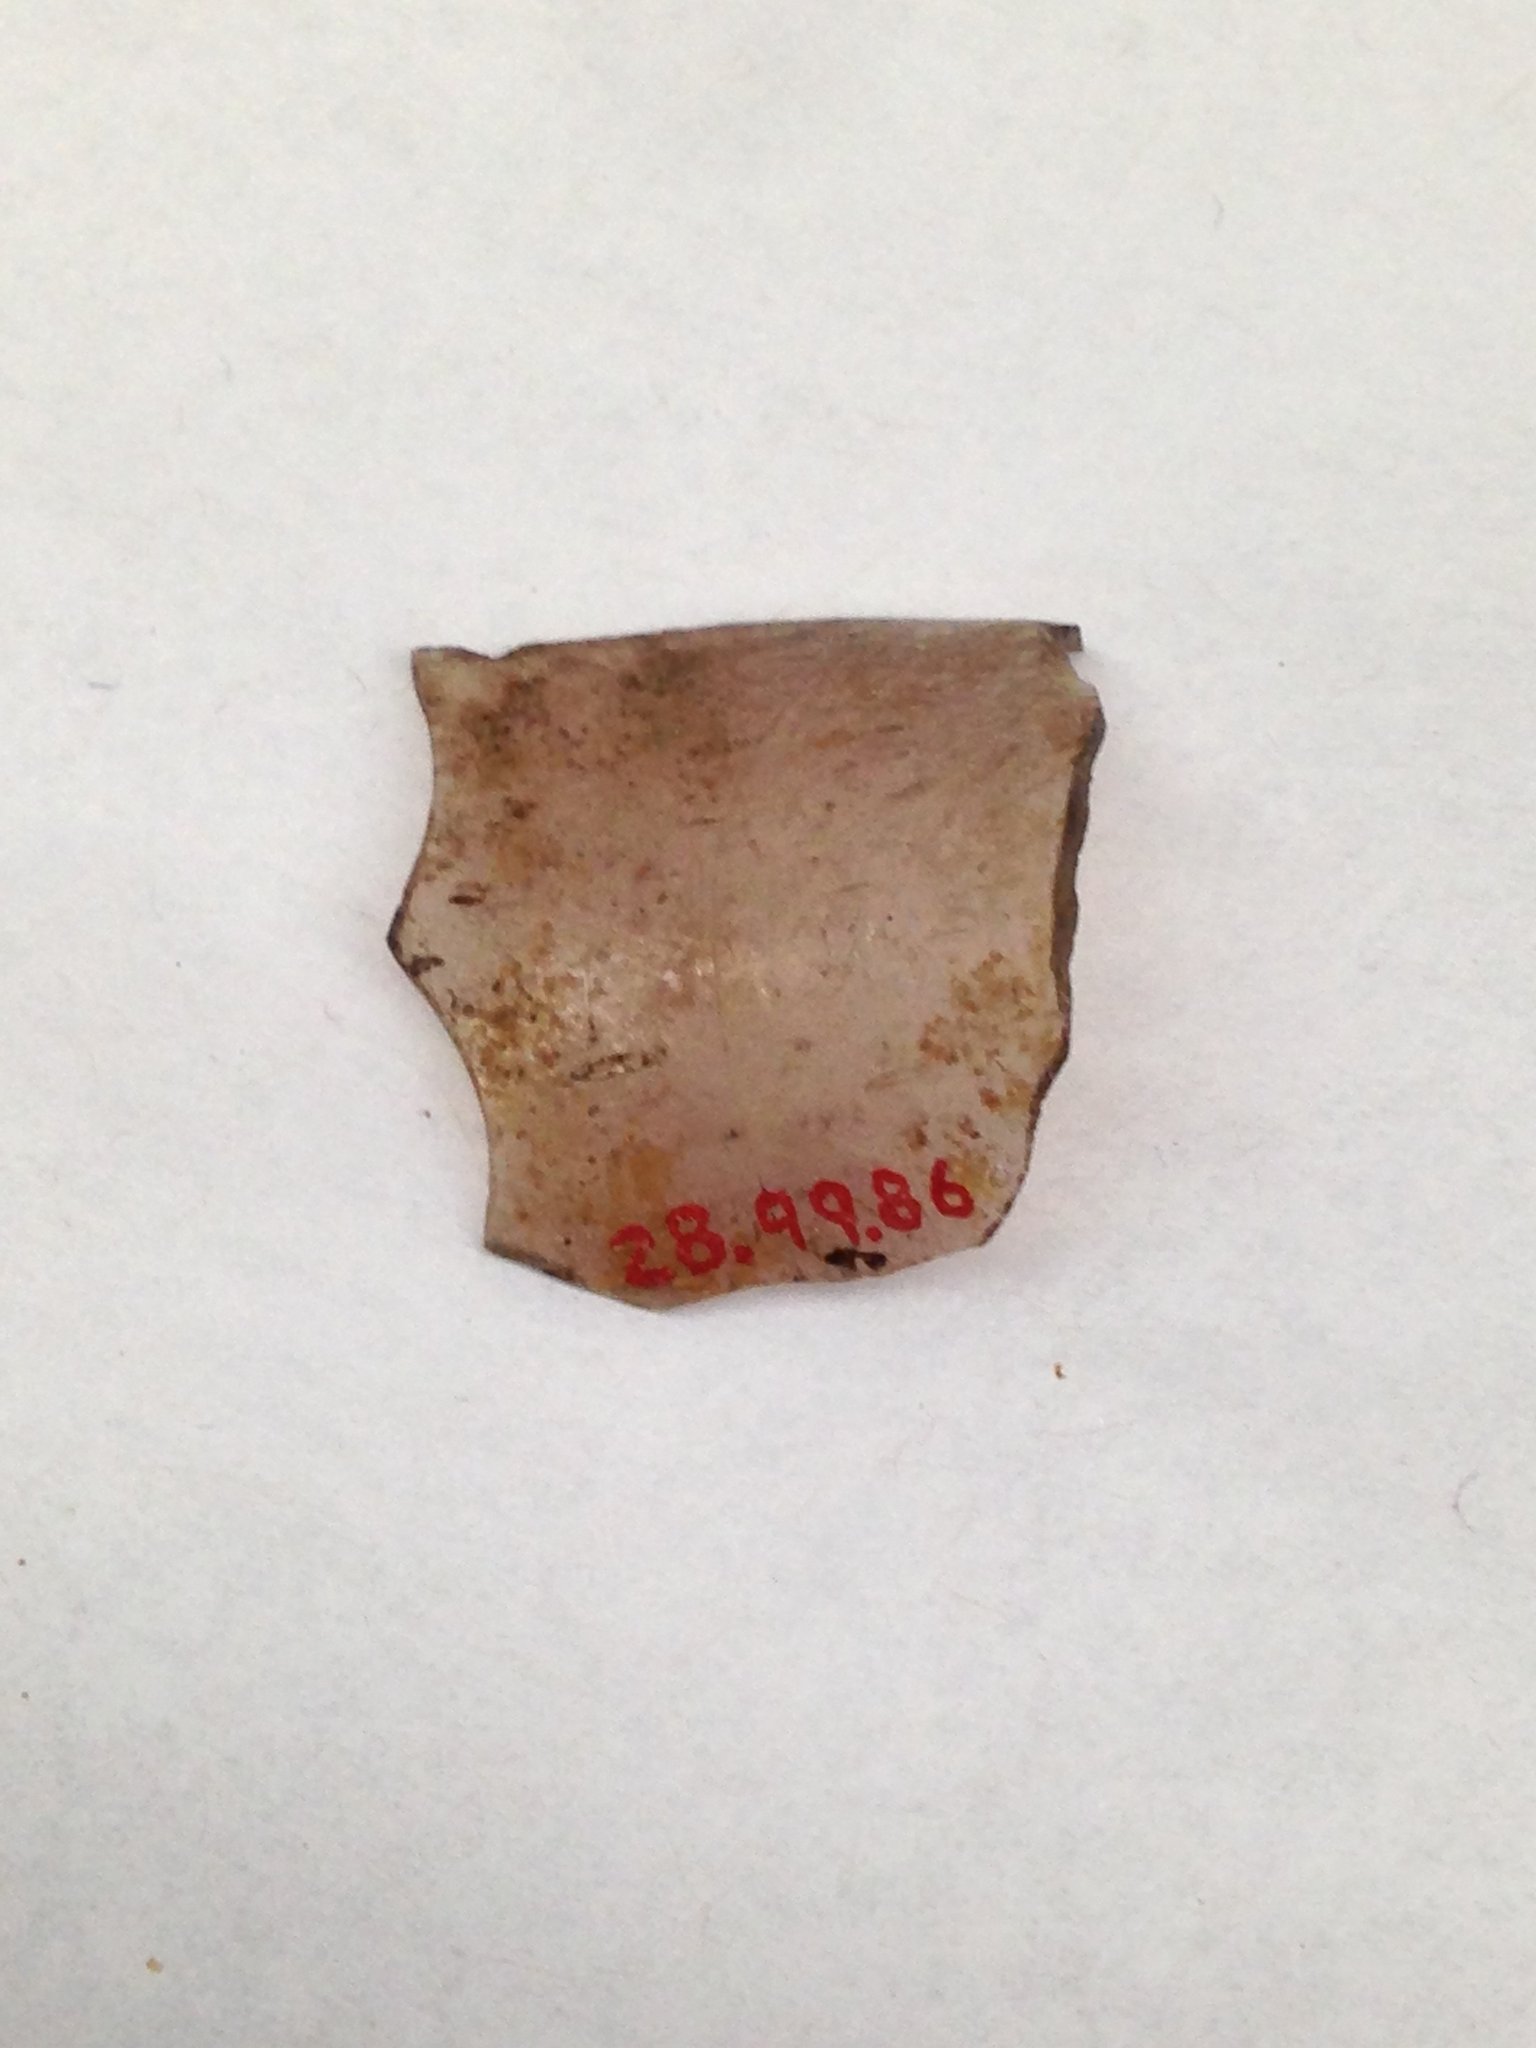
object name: fragment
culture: european or middle eastern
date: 1150-1250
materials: ceramic, glass